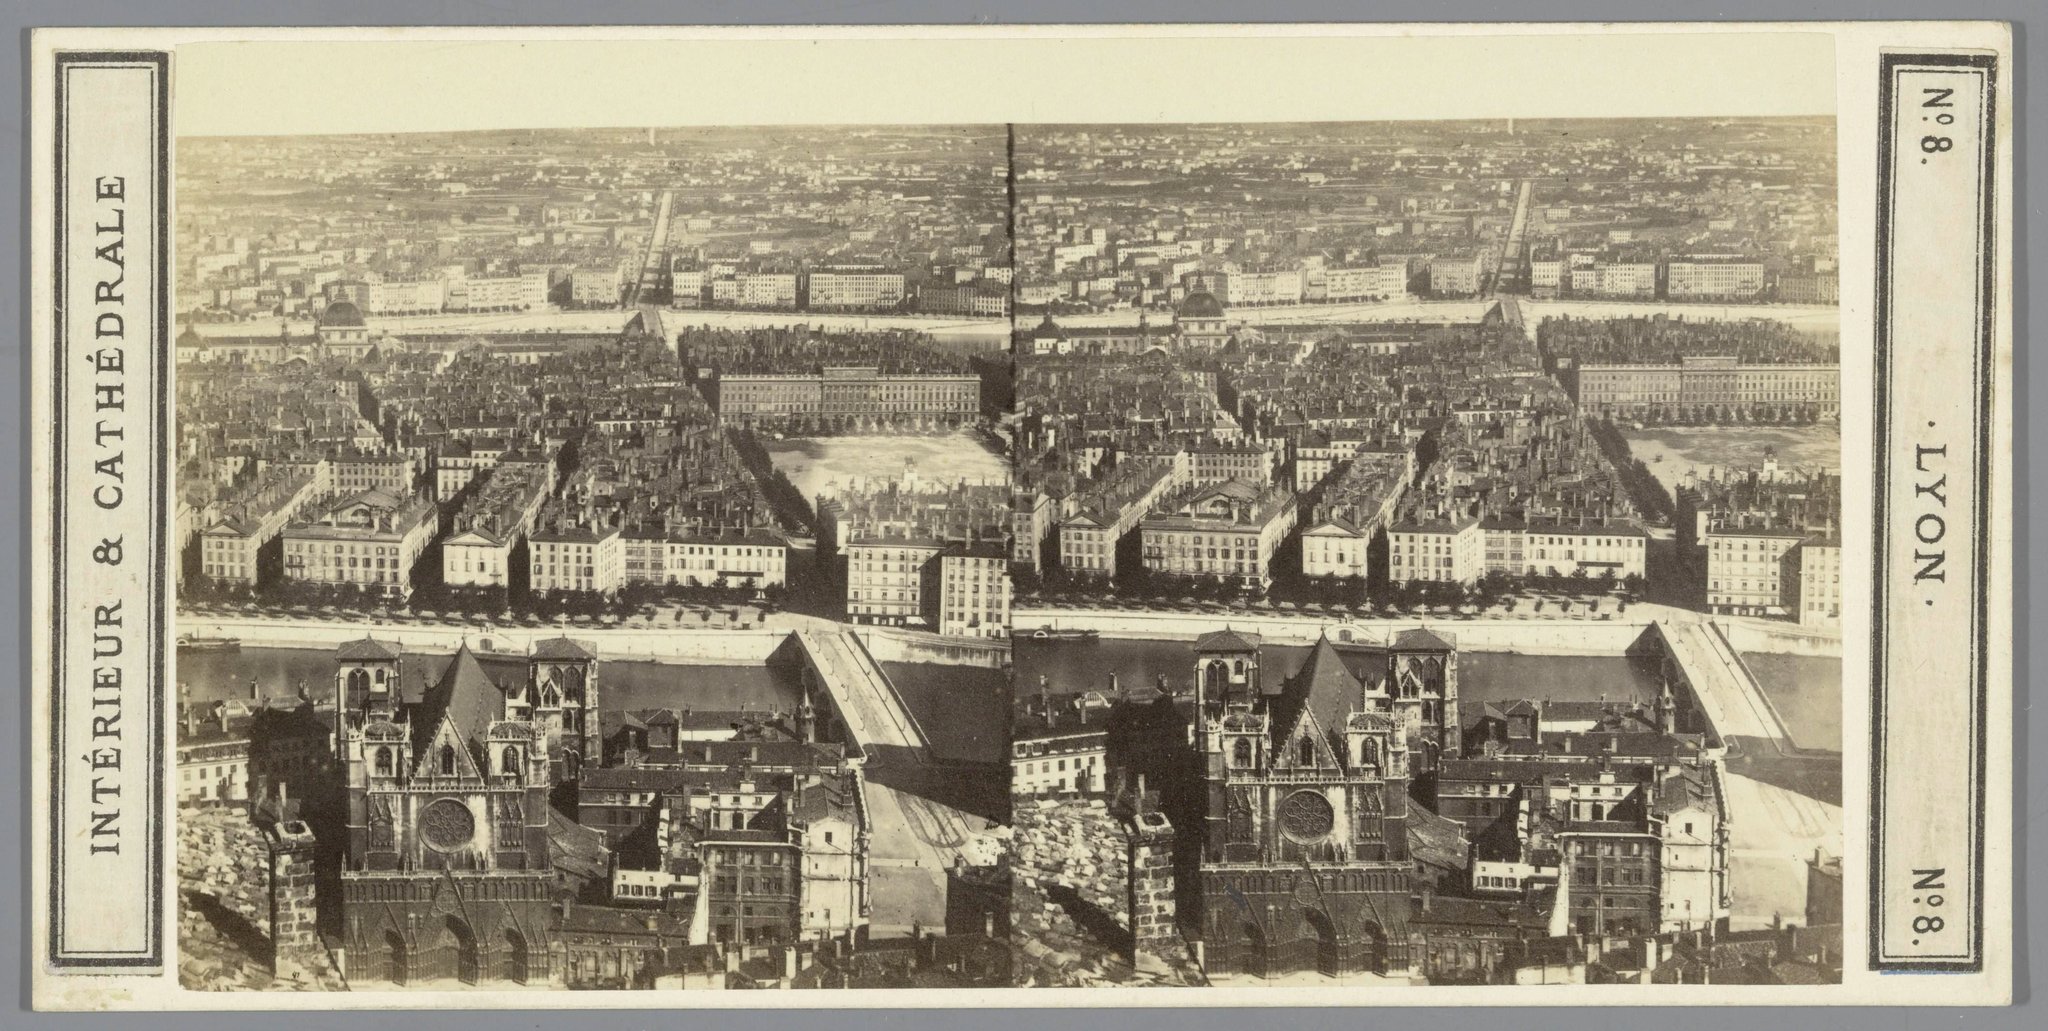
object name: stereograph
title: Lyon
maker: Anonymous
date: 1860-1865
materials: cardboard, photographic support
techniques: albumen print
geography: lyon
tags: city-view in general; 'veduta', lyon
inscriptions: inscription: ‘Observatoire Gay à Fourvières Succursale 52, Rue Impériale, 52 Lyon’, number: ‘No. 8.’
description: RP-F-F06569 is een ander exemplaar van dezelfde foto.